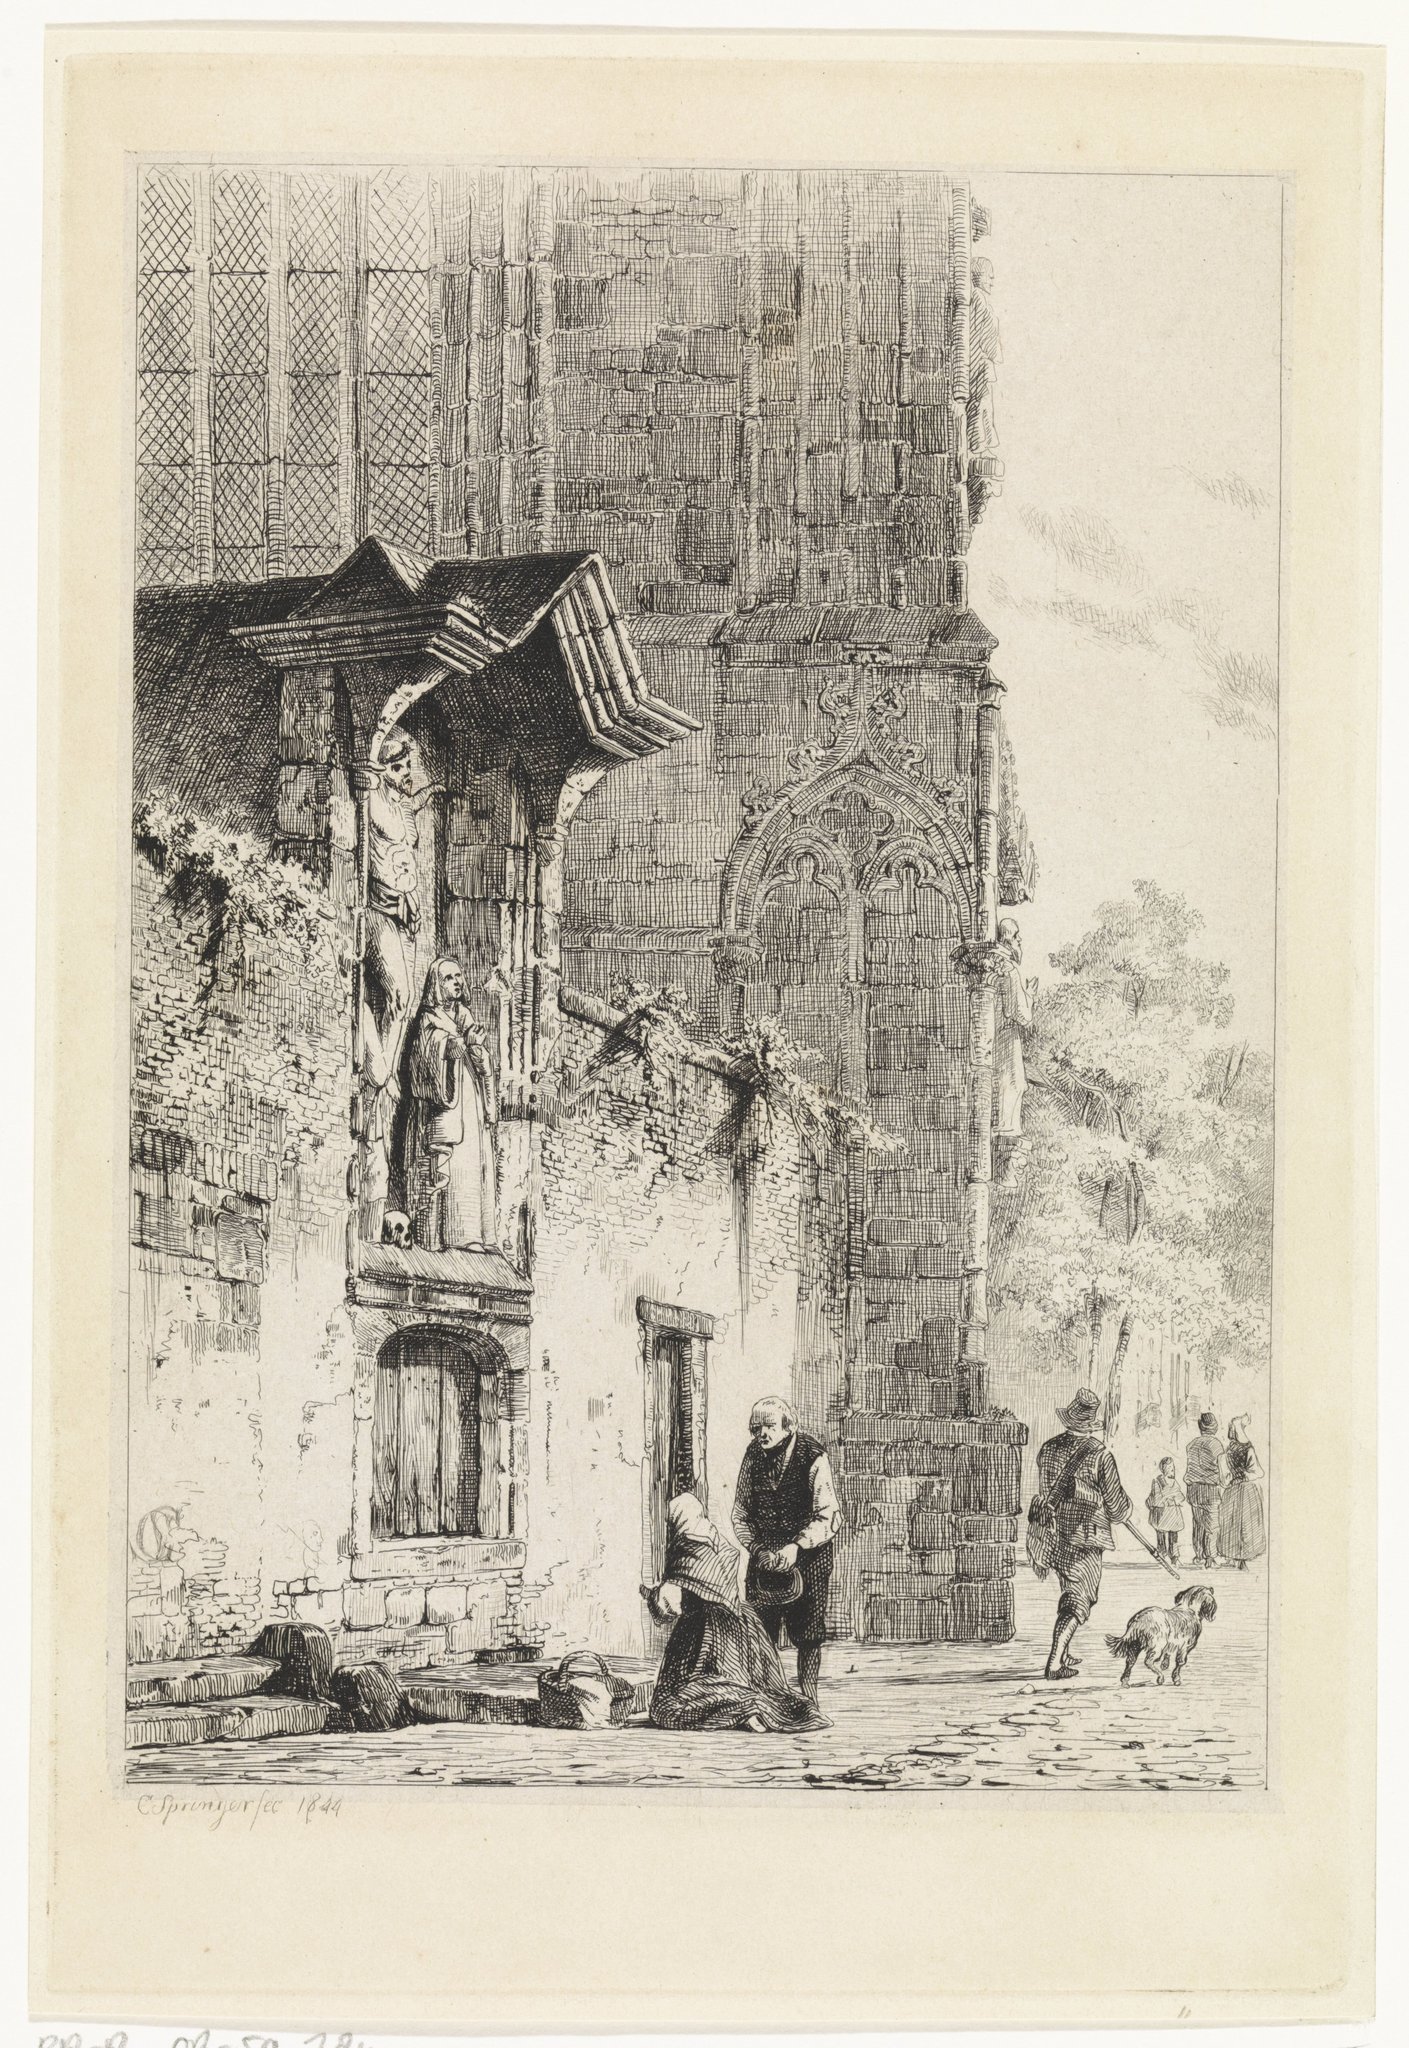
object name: print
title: Vrouw knielend voor een kapelletje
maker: cornelis springer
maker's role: draughtsman, painter, print maker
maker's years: 1817-1891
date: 1844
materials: paper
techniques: drypoint, etching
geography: amsterdam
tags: parts of church exterior and annexes: chapel, crucifix ~ personal devotion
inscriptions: collector's mark: Lugt 2228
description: Een vrouw knielt voor een kappelletje, waarin een kruisbeeld hangt, aan de buitenzijde van een kerk. Een man staat met zijn hoed in de handen naast haar.